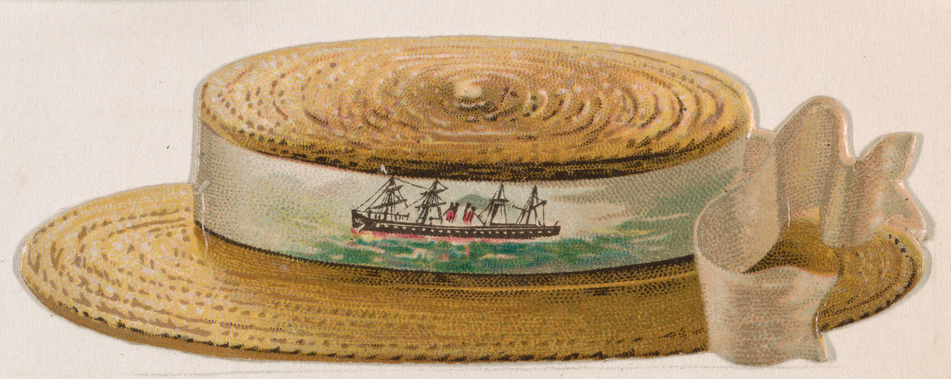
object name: print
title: Hat, from the Novelties series (N228, Type 4) issued by Kinney Bros.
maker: kinney brothers tobacco company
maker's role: publisher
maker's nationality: american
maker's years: 1869-2011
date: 1889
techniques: color lithograph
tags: hats